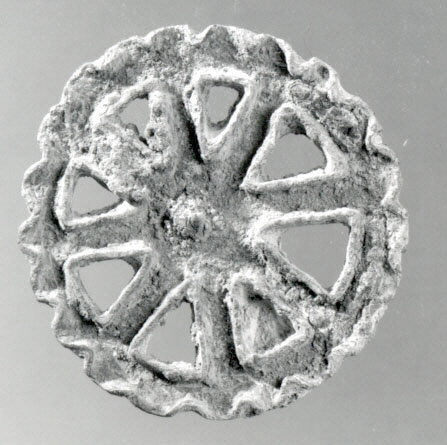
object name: stamp seal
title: Compartmented stamp seal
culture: bactria-margiana archaeological complex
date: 2333-1668 BCE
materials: copper alloy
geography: bactria-margiana